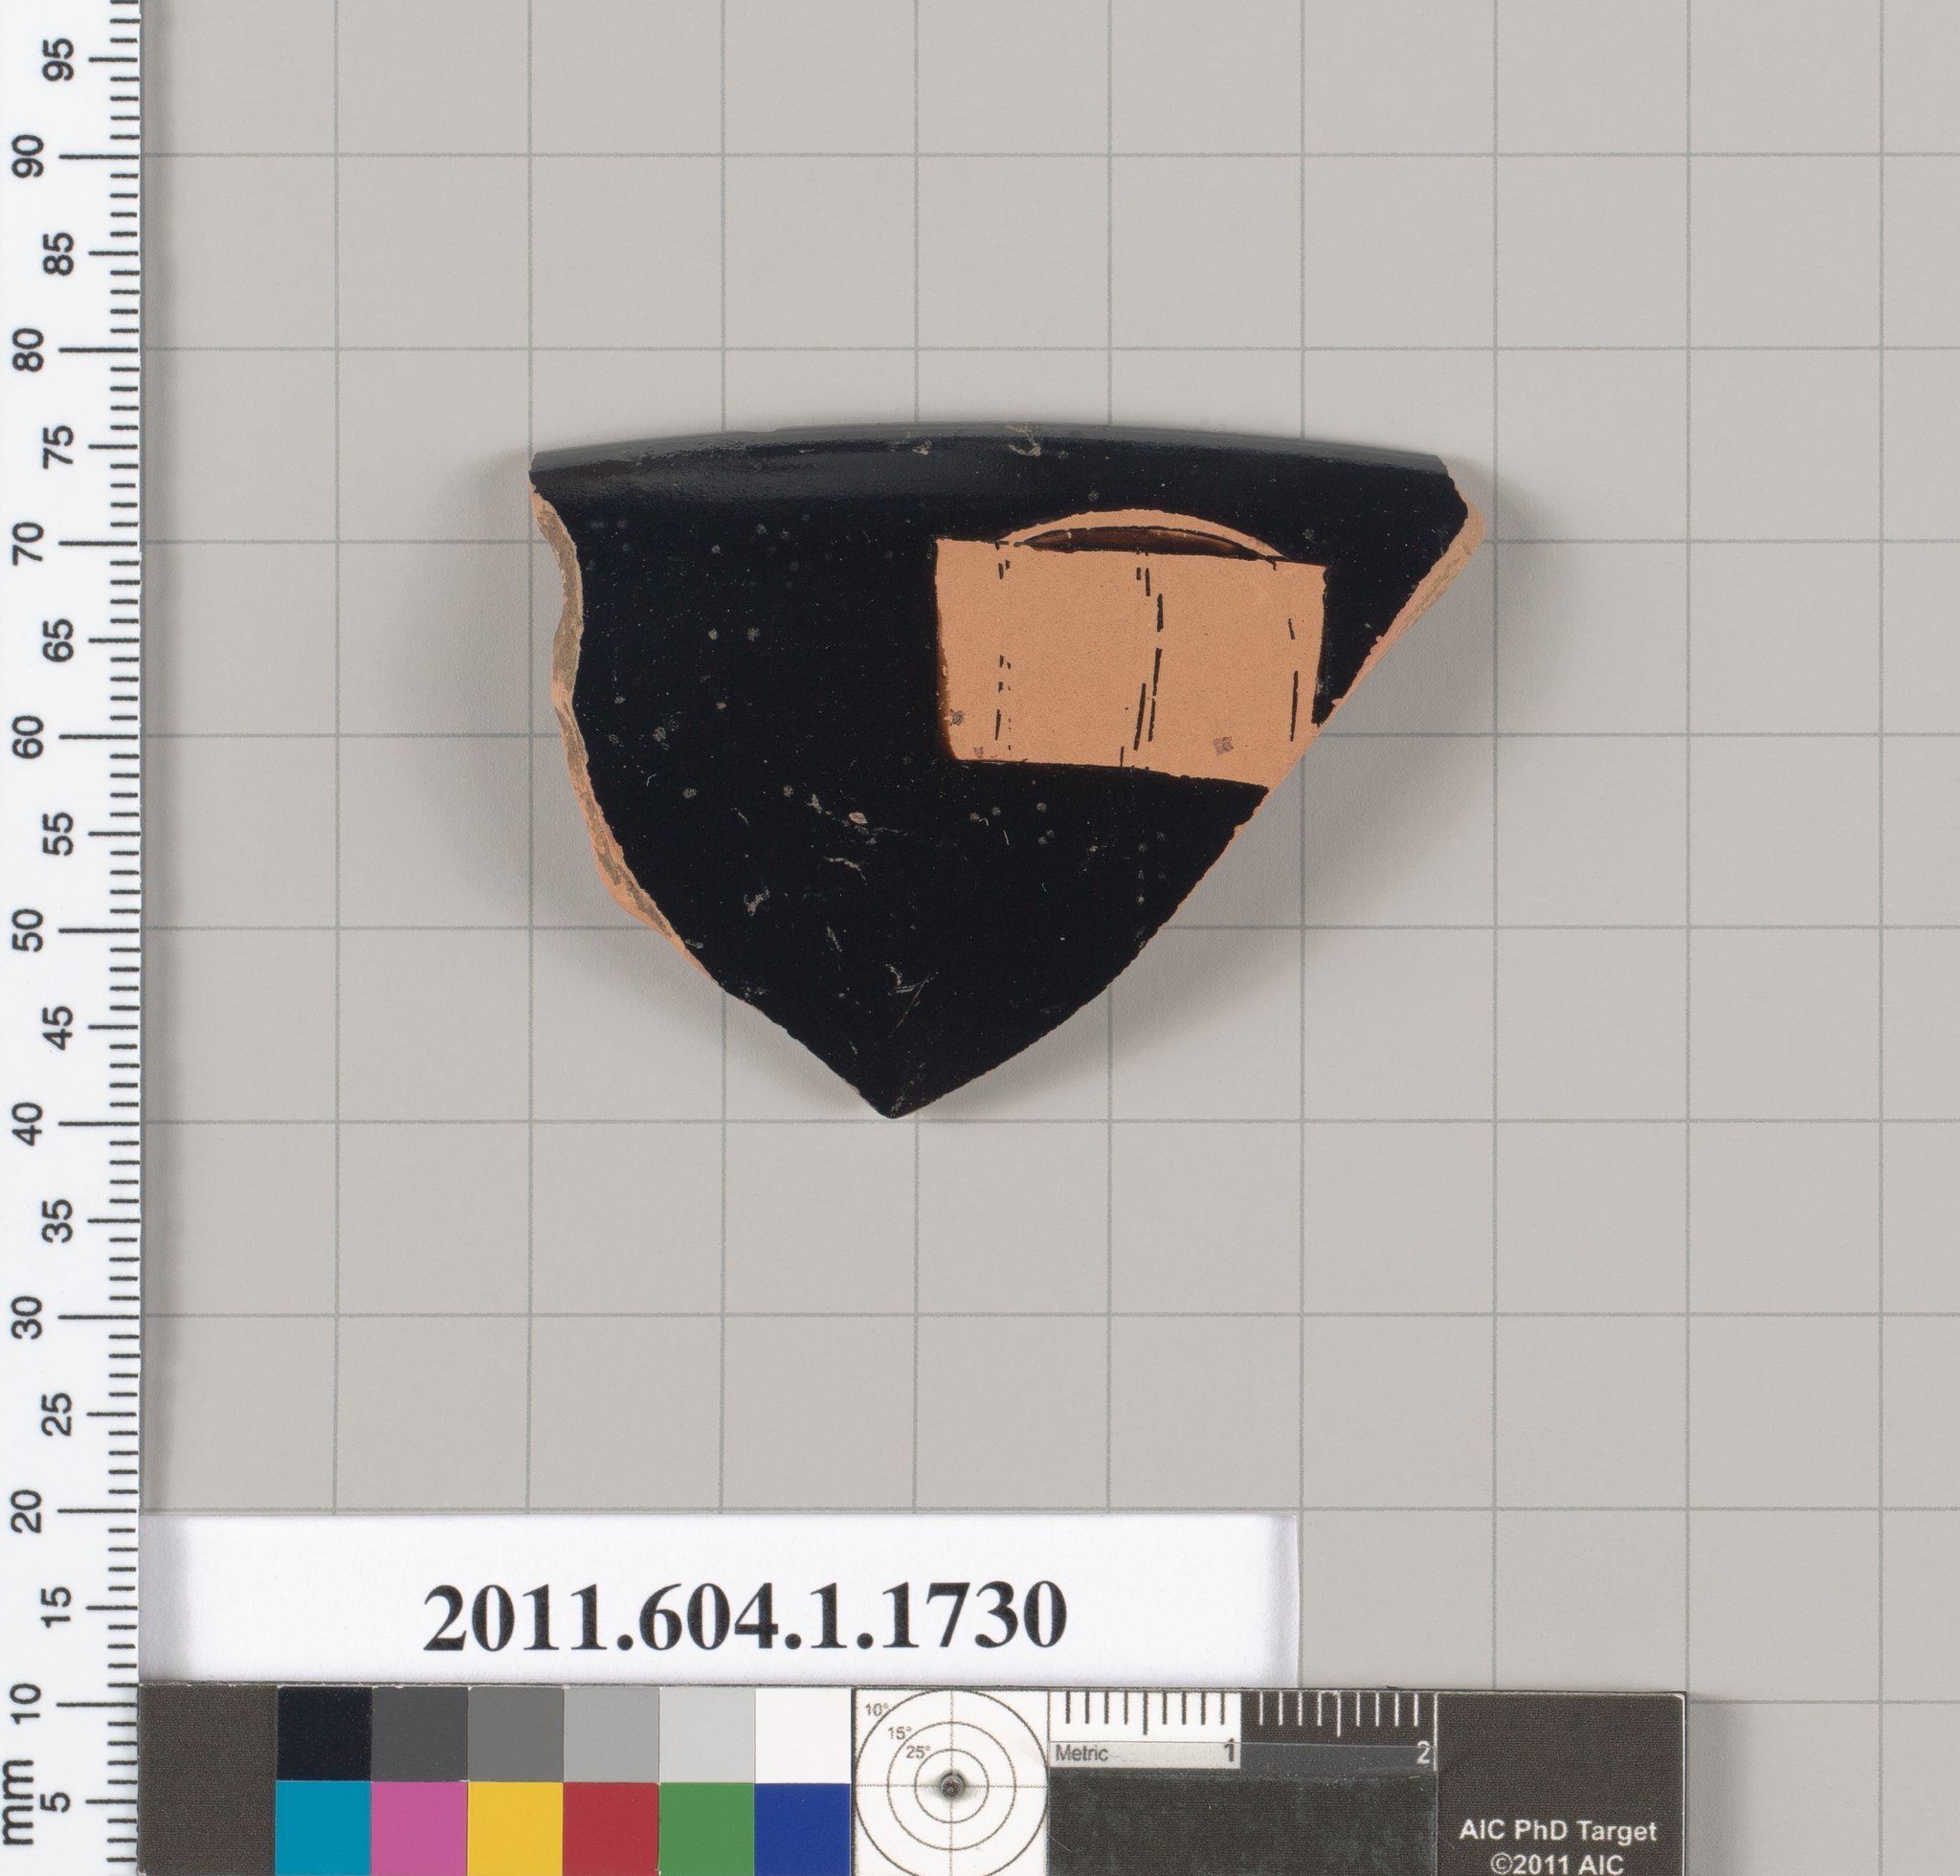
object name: kylix fragment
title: Terracotta rim fragment of a kylix (drinking cup)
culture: greek, attic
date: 490-480 BCE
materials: terracotta